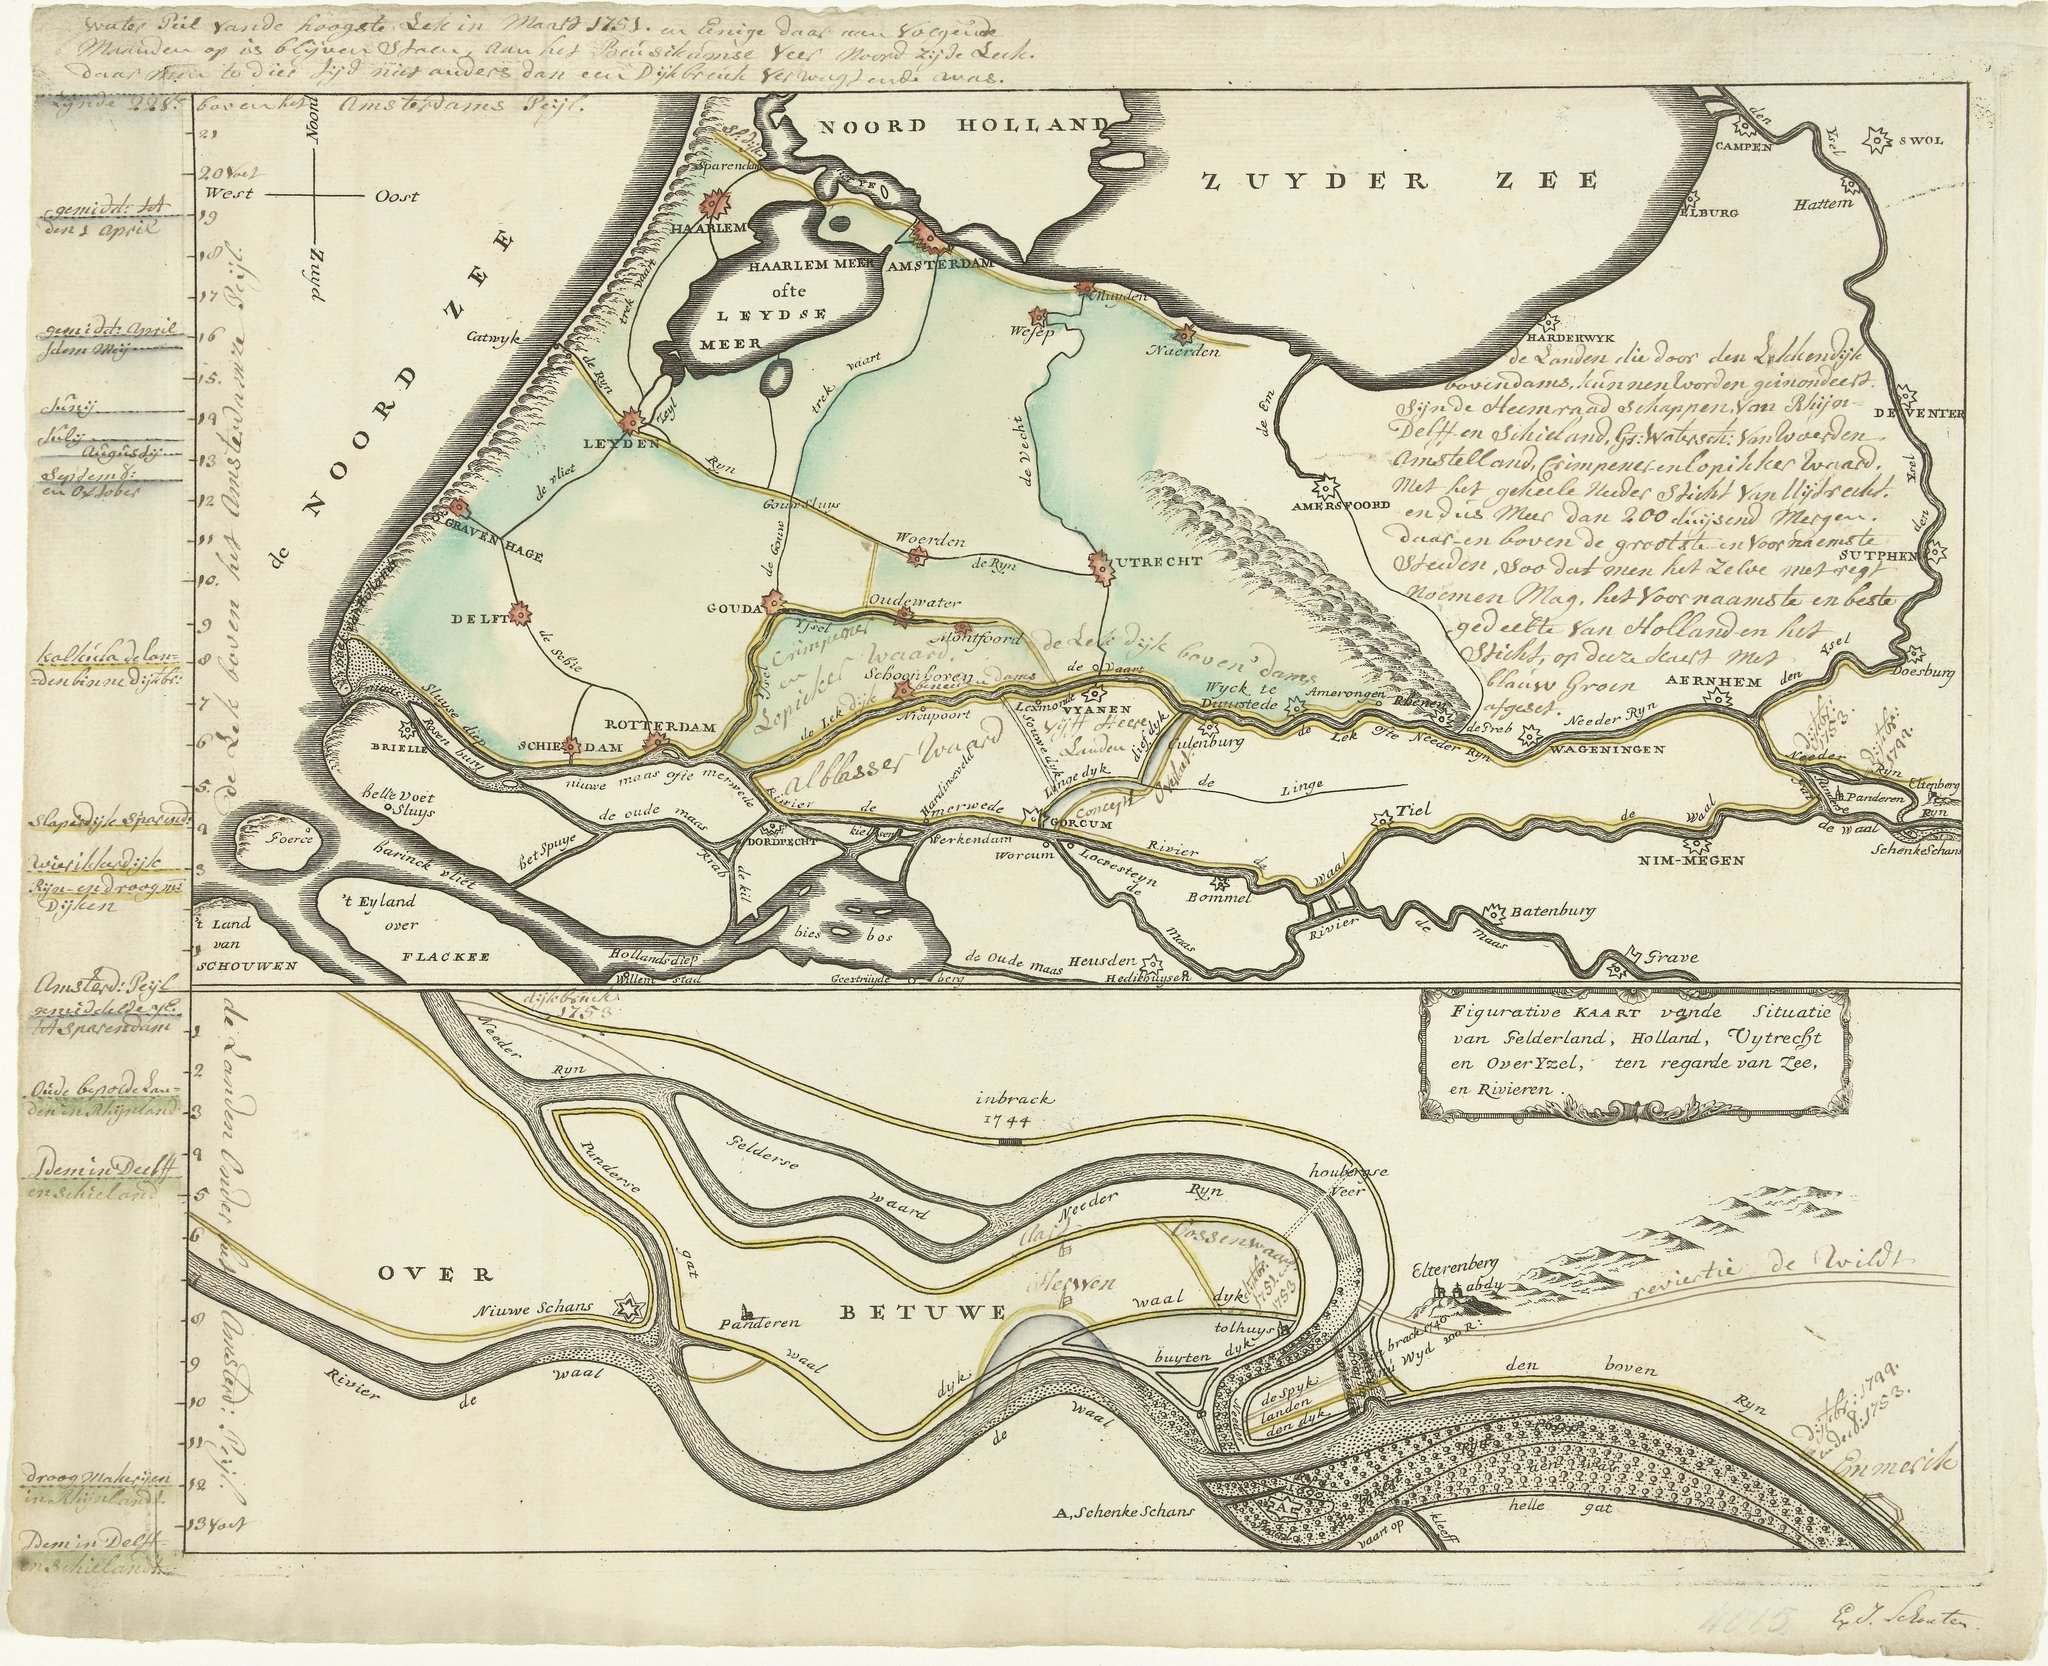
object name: print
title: Figurative Kaart vande Situatie van Gelderland, Holland, Uytrecht en OverYzel, ten regarde van Zee, en Rivieren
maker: Anonymous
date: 1751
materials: paper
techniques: etching, hand coloring, writing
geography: northern netherlands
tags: maps of separate countries or regions, dikes, levee, utrecht, gelderland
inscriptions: collector's mark: Lugt 2228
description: Kaart van het rivierengebied in Holland, Utrecht en Gelderland met de hoge waterstand in de rivieren de Lek en de Waal, maart 1751. Links waterstanden onder en boven Amsterdams Peil. Met verschillende teksten en opschriften in handschrift in de voorstelling. Rechtsonder de vermelding van een naam: Ey. J. Schouten.